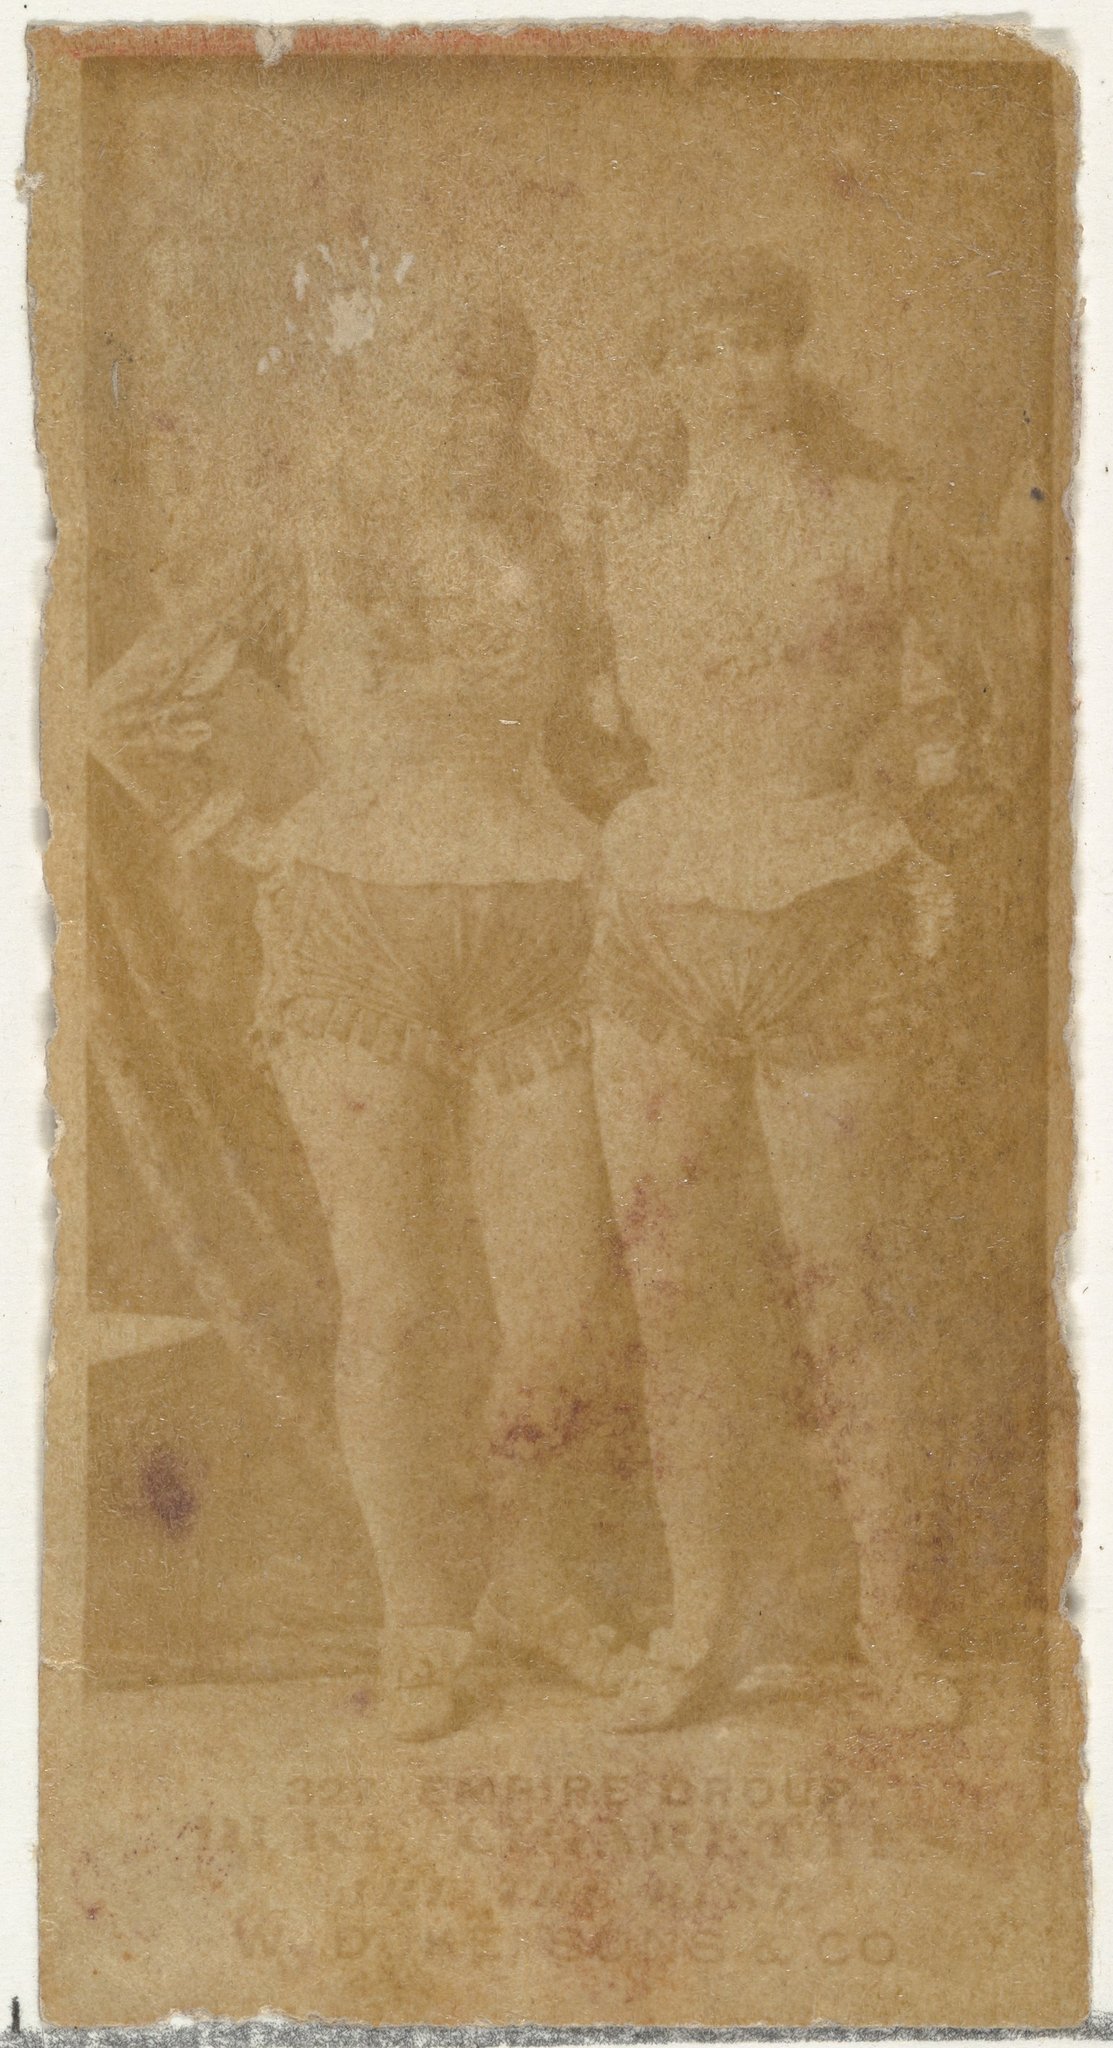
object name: photograph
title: Card Number 322, Empire Group, from the Actors and Actresses series (N145-7) issued by Duke Sons & Co. to promote Duke Cigarettes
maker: w. duke, sons & co.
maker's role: publisher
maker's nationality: american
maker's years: 1870-1920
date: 1880-1889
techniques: albumen silver print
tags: portraits,women,actresses